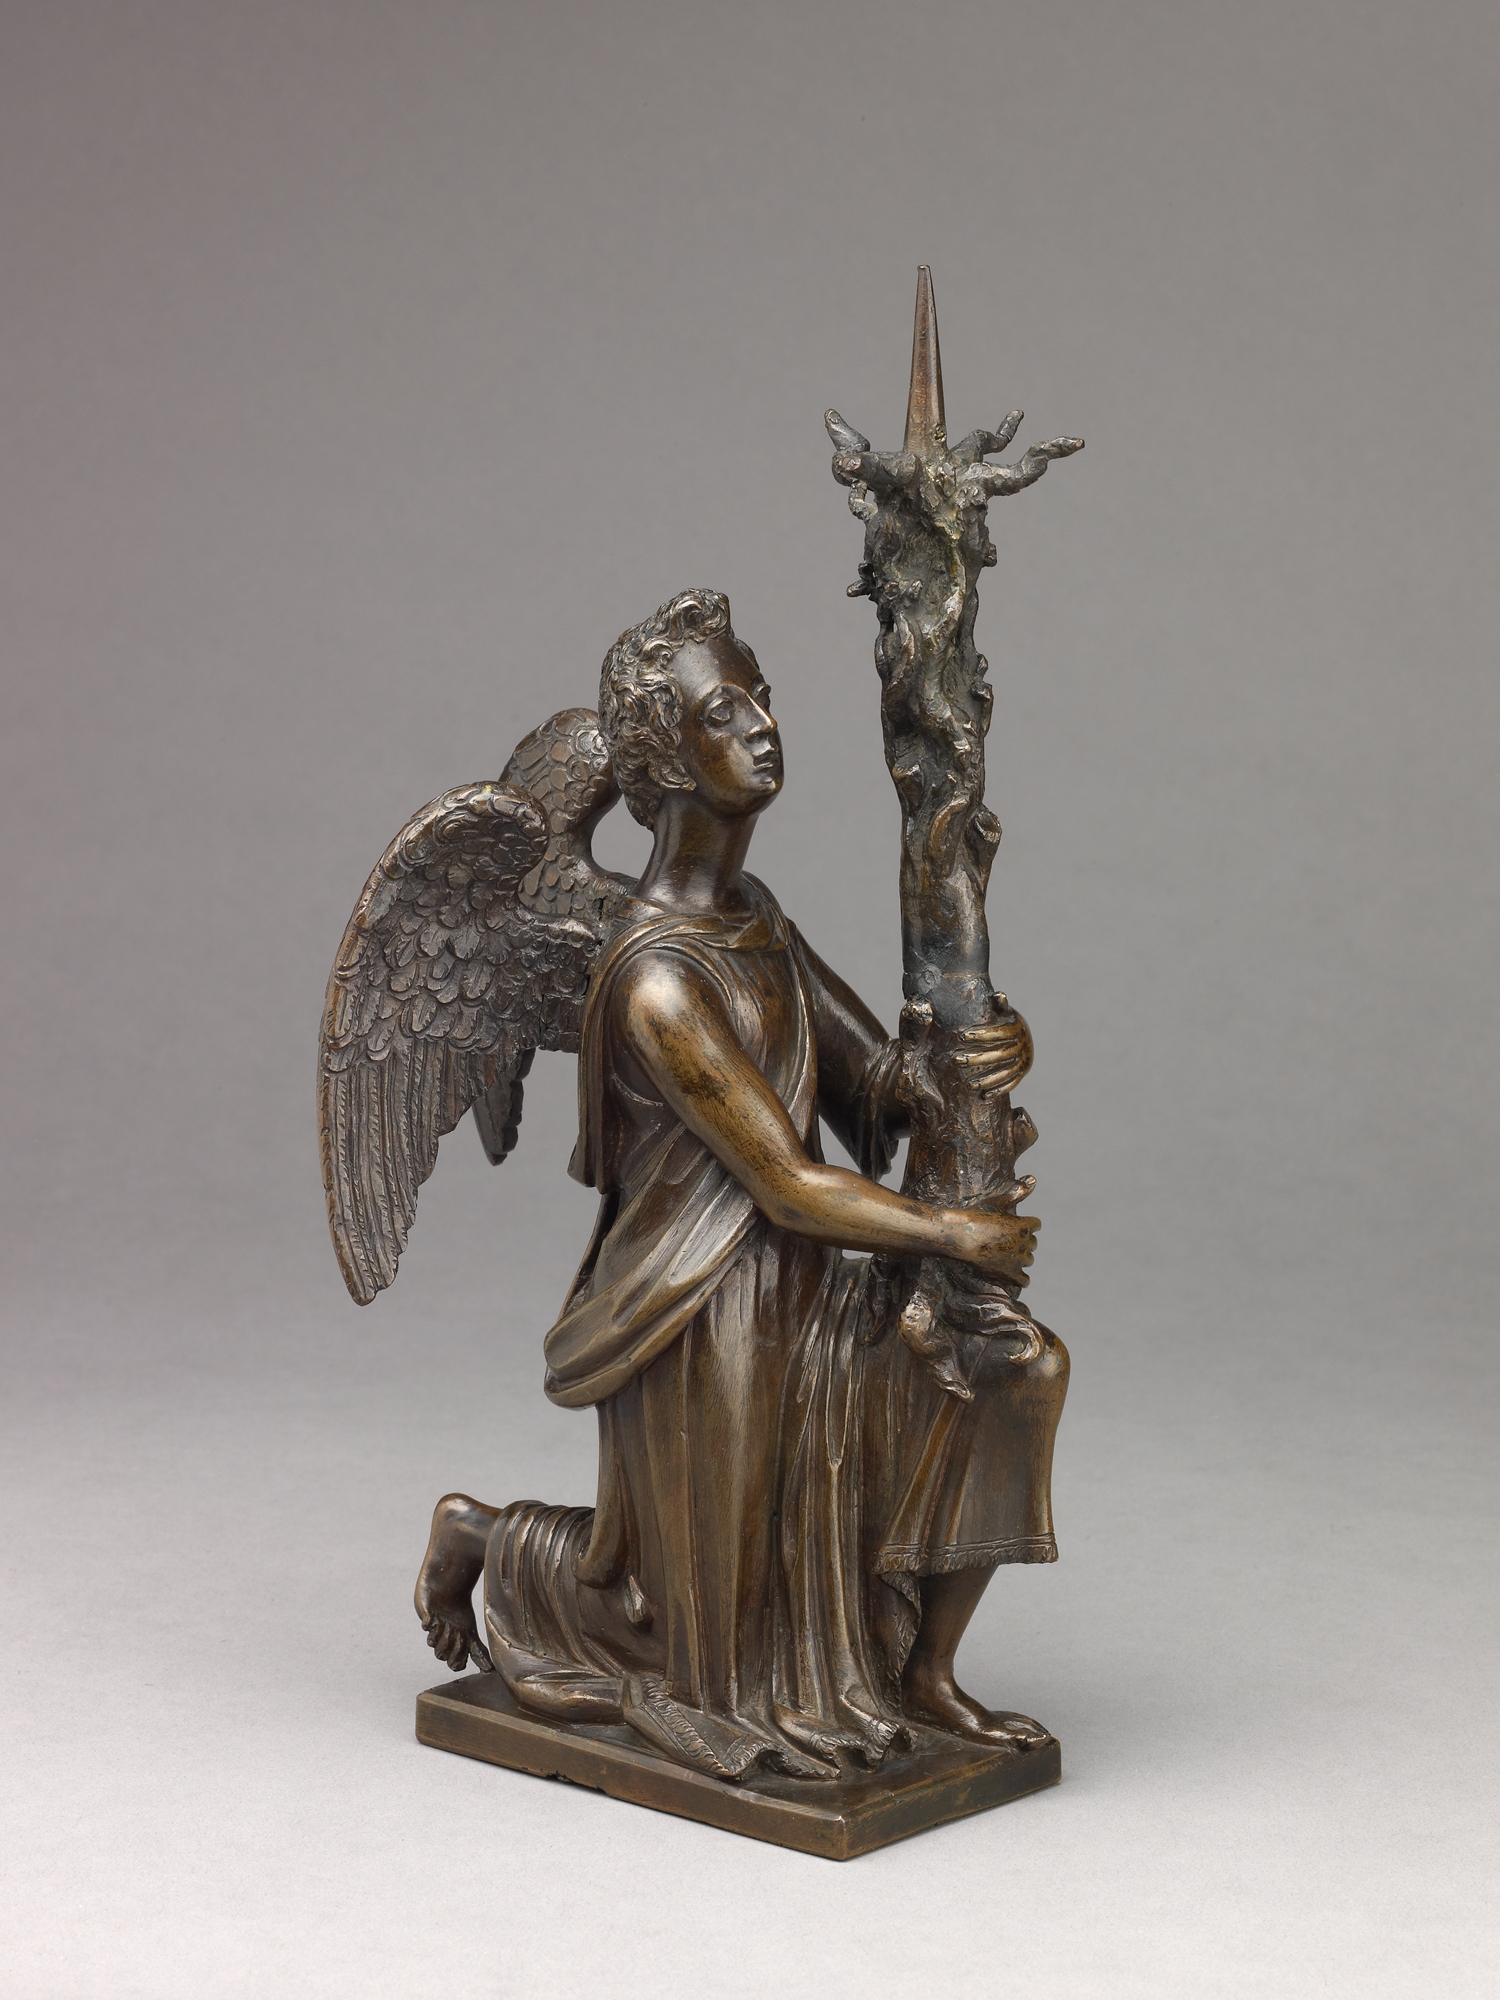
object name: candelabrum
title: Candlestick in the Form of a Kneeling Angel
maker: giambologna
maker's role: artist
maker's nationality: netherlandish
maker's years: 1529-1608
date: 1590-1600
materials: copper alloy, patina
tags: angels